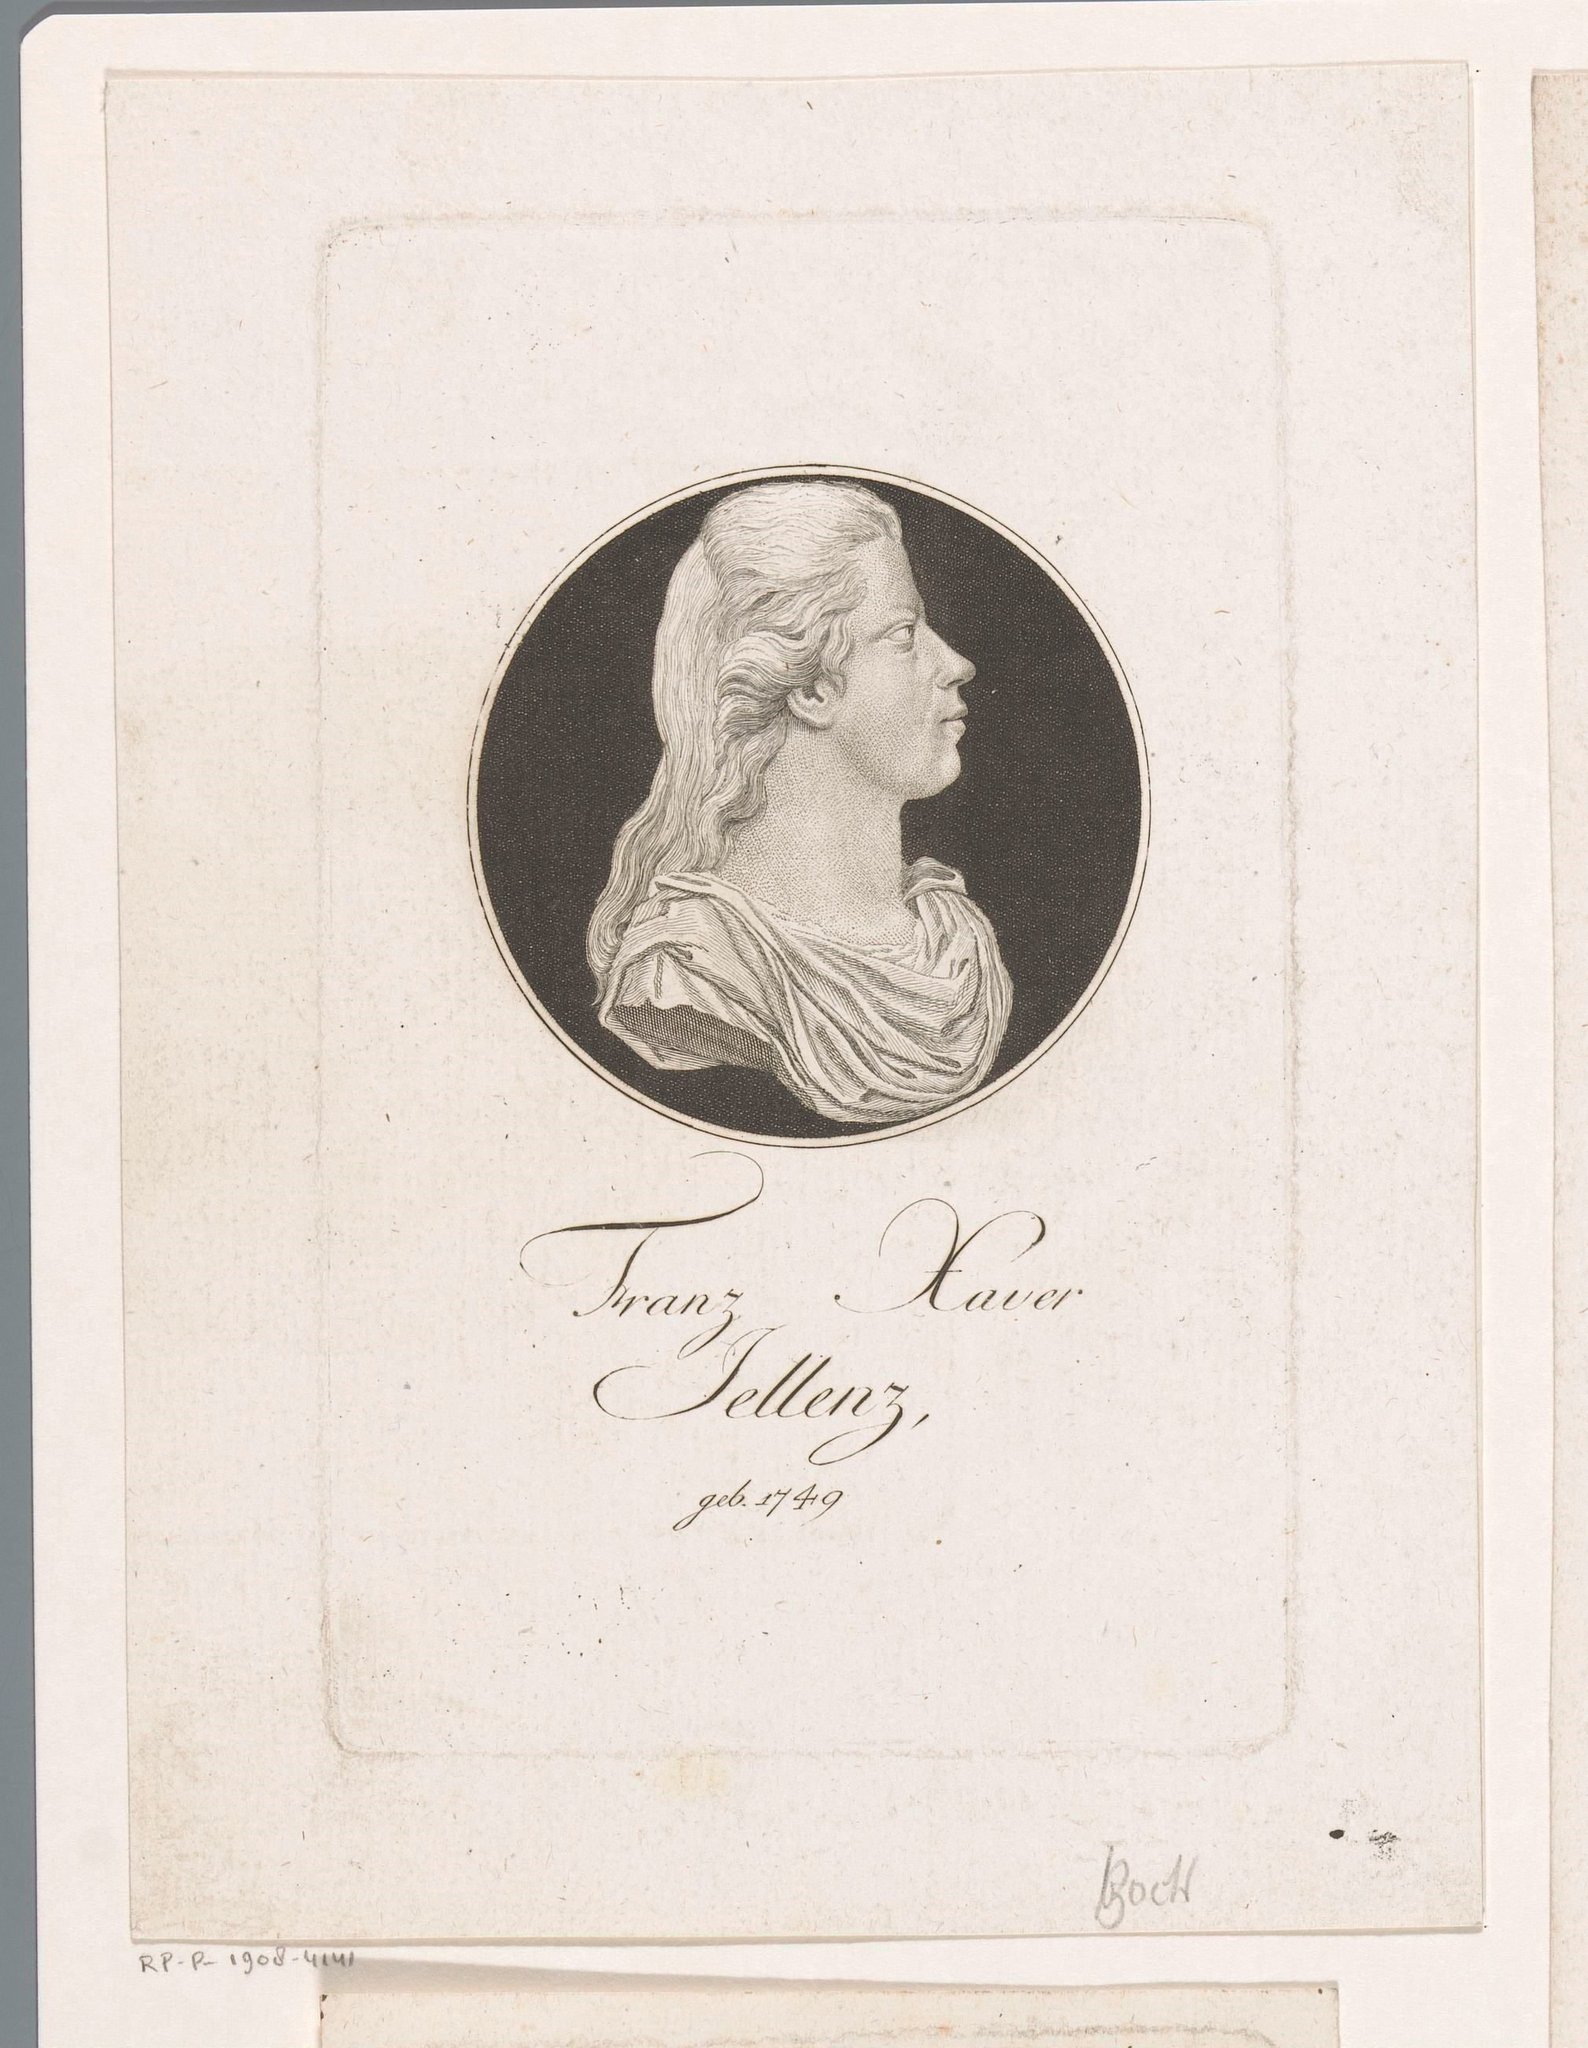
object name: print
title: Portret van Franz Xaver Jellenz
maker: christoph wilhelm bock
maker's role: print maker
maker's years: 1755-1836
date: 1795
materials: paper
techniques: engraving, etching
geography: nuremberg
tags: historical persons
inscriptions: collector's mark: Lugt 2228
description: Op verso een fragment van het portret dat Christoph Wilhelm Bock in 1794 maakte van Christian Gottfried Junge.